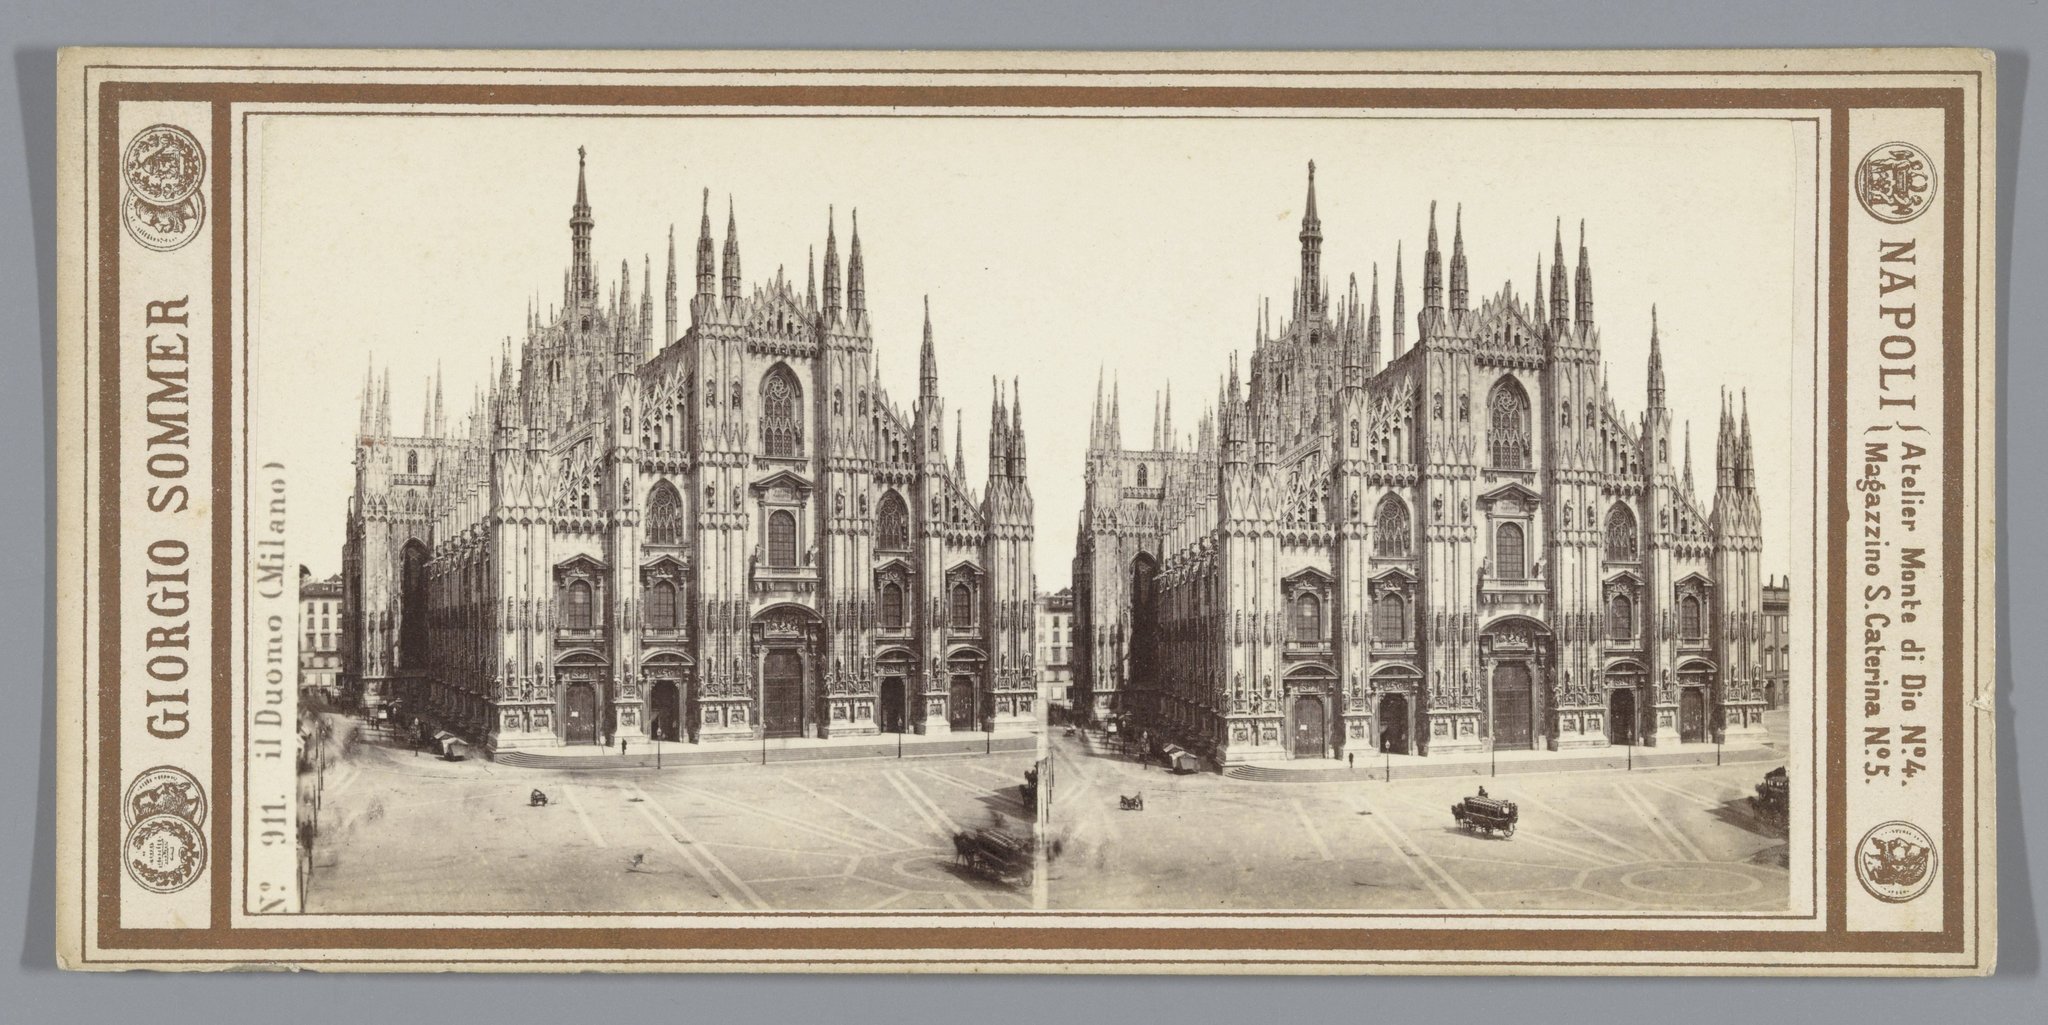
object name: stereograph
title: Gezicht op de Dom in Milaan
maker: giorgio sommer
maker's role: fotograaf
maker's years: 1834-1914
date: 1860-1880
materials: cardboard, photographic support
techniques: albumen print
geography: milan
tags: church (exterior)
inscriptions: number: ‘No. 911.’